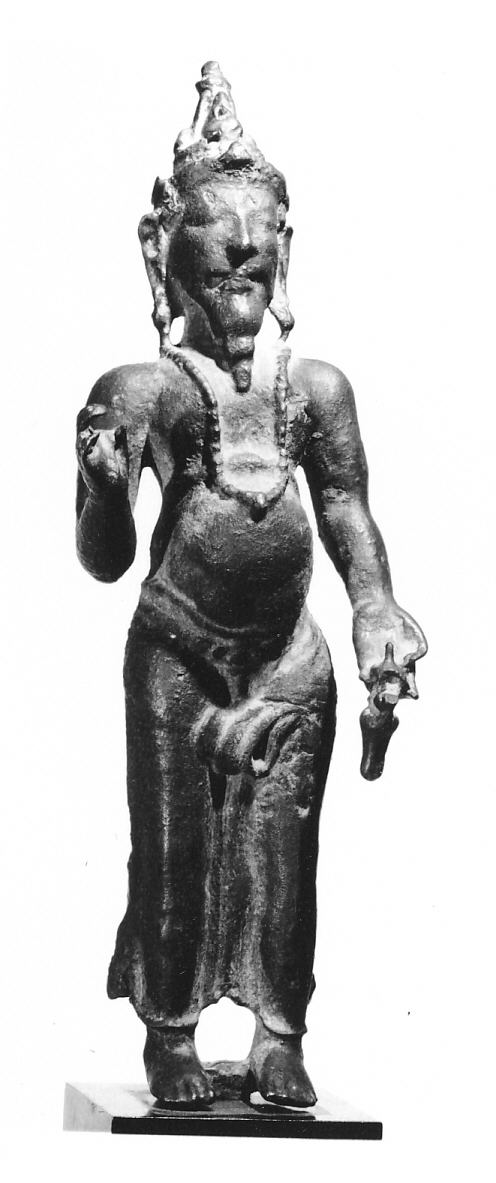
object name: figure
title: Standing Deified Sage Agastya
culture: indonesian, javanese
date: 801-900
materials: bronze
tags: men,hinduism